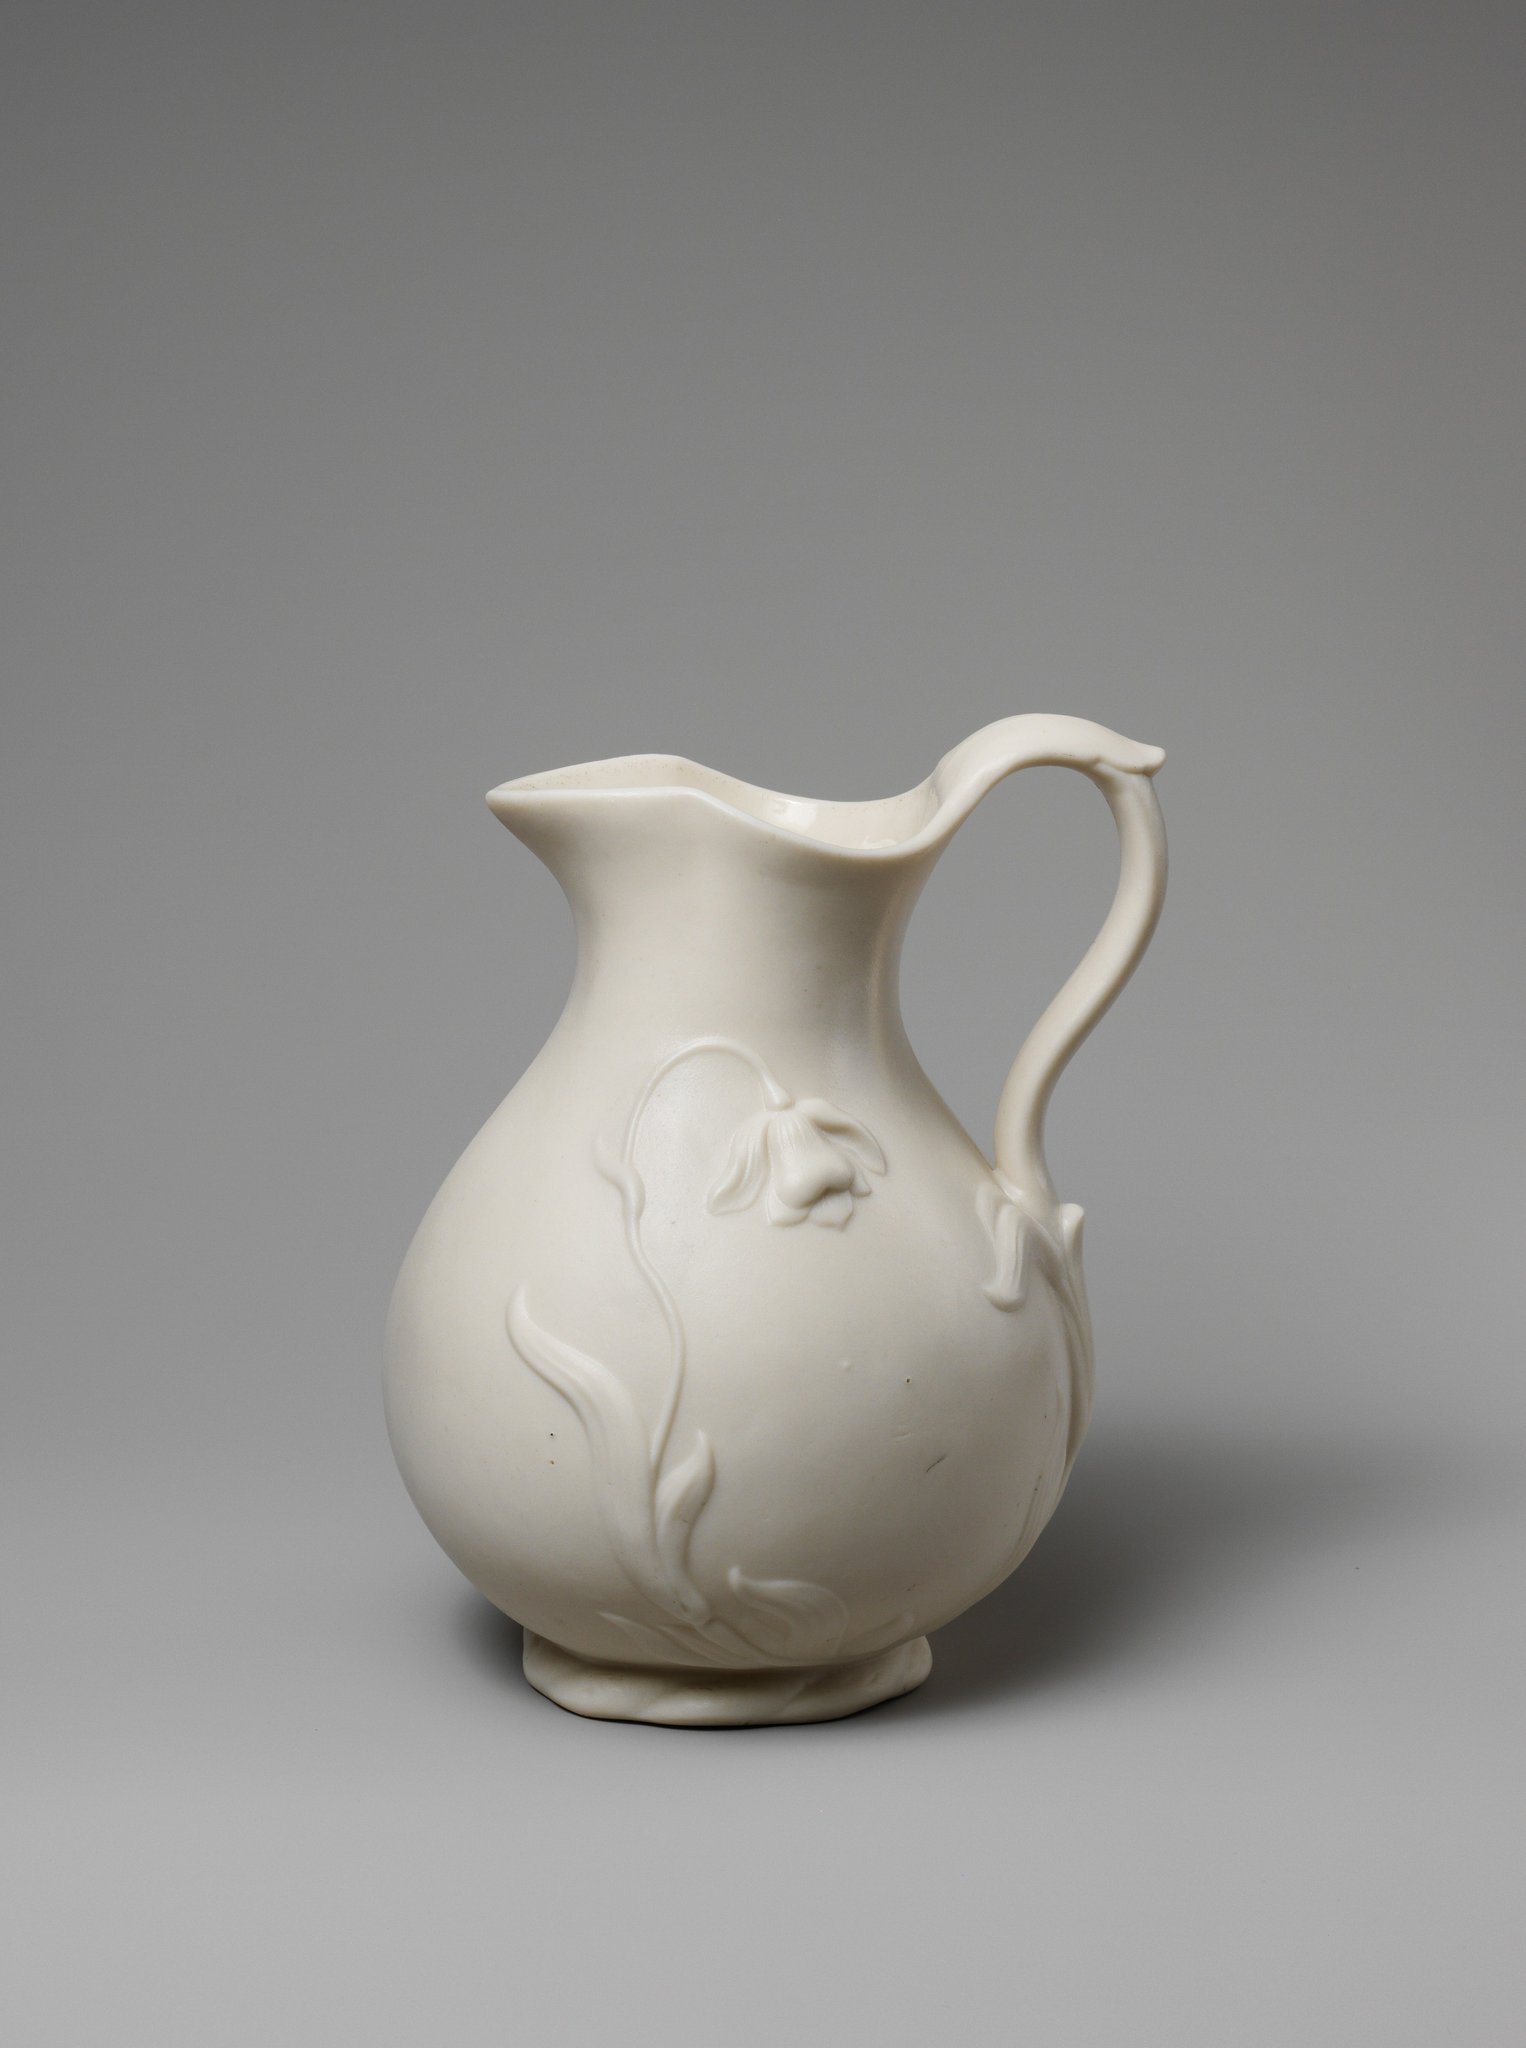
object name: pitcher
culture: american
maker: fenton's works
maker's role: maker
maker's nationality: american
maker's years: 1847-1848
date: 1847-1848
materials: porcelain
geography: united states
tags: flowers